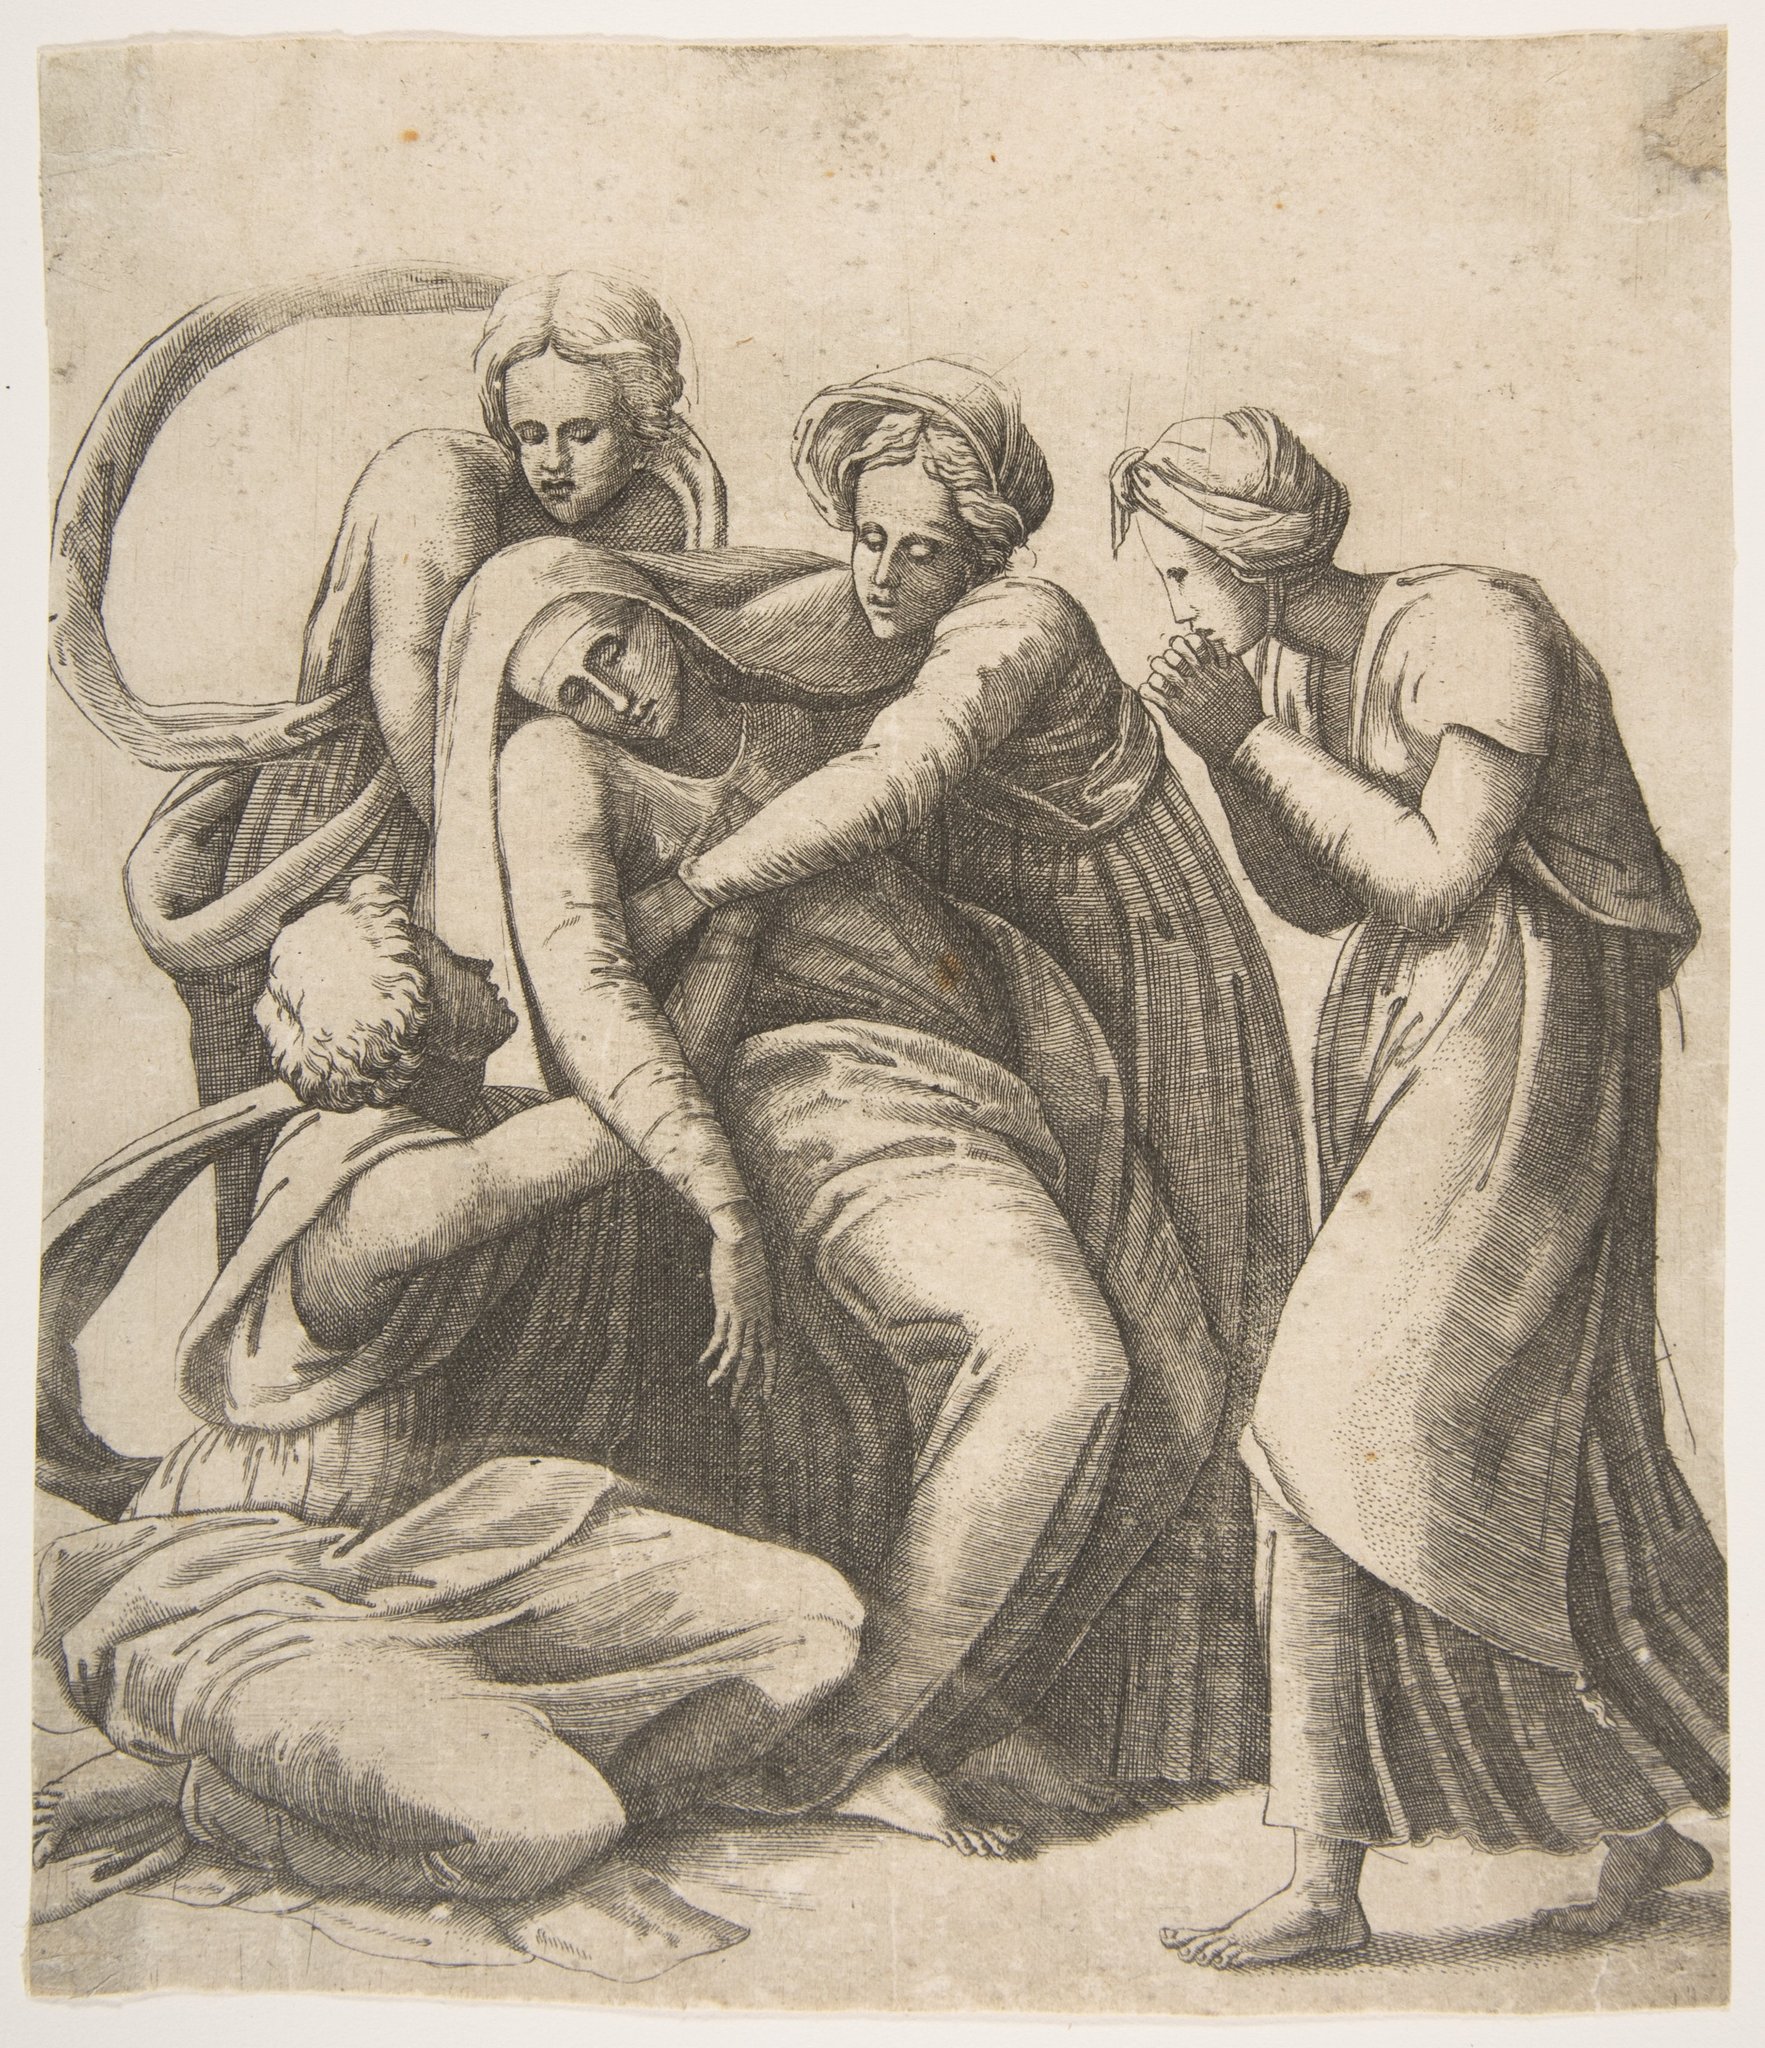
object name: print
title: The Virgin fainting and being supported in the arms of the holy women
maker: giulio bonasone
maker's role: artist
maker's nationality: italian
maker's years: 1510-1576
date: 1531-1576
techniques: engraving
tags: women,virgin mary